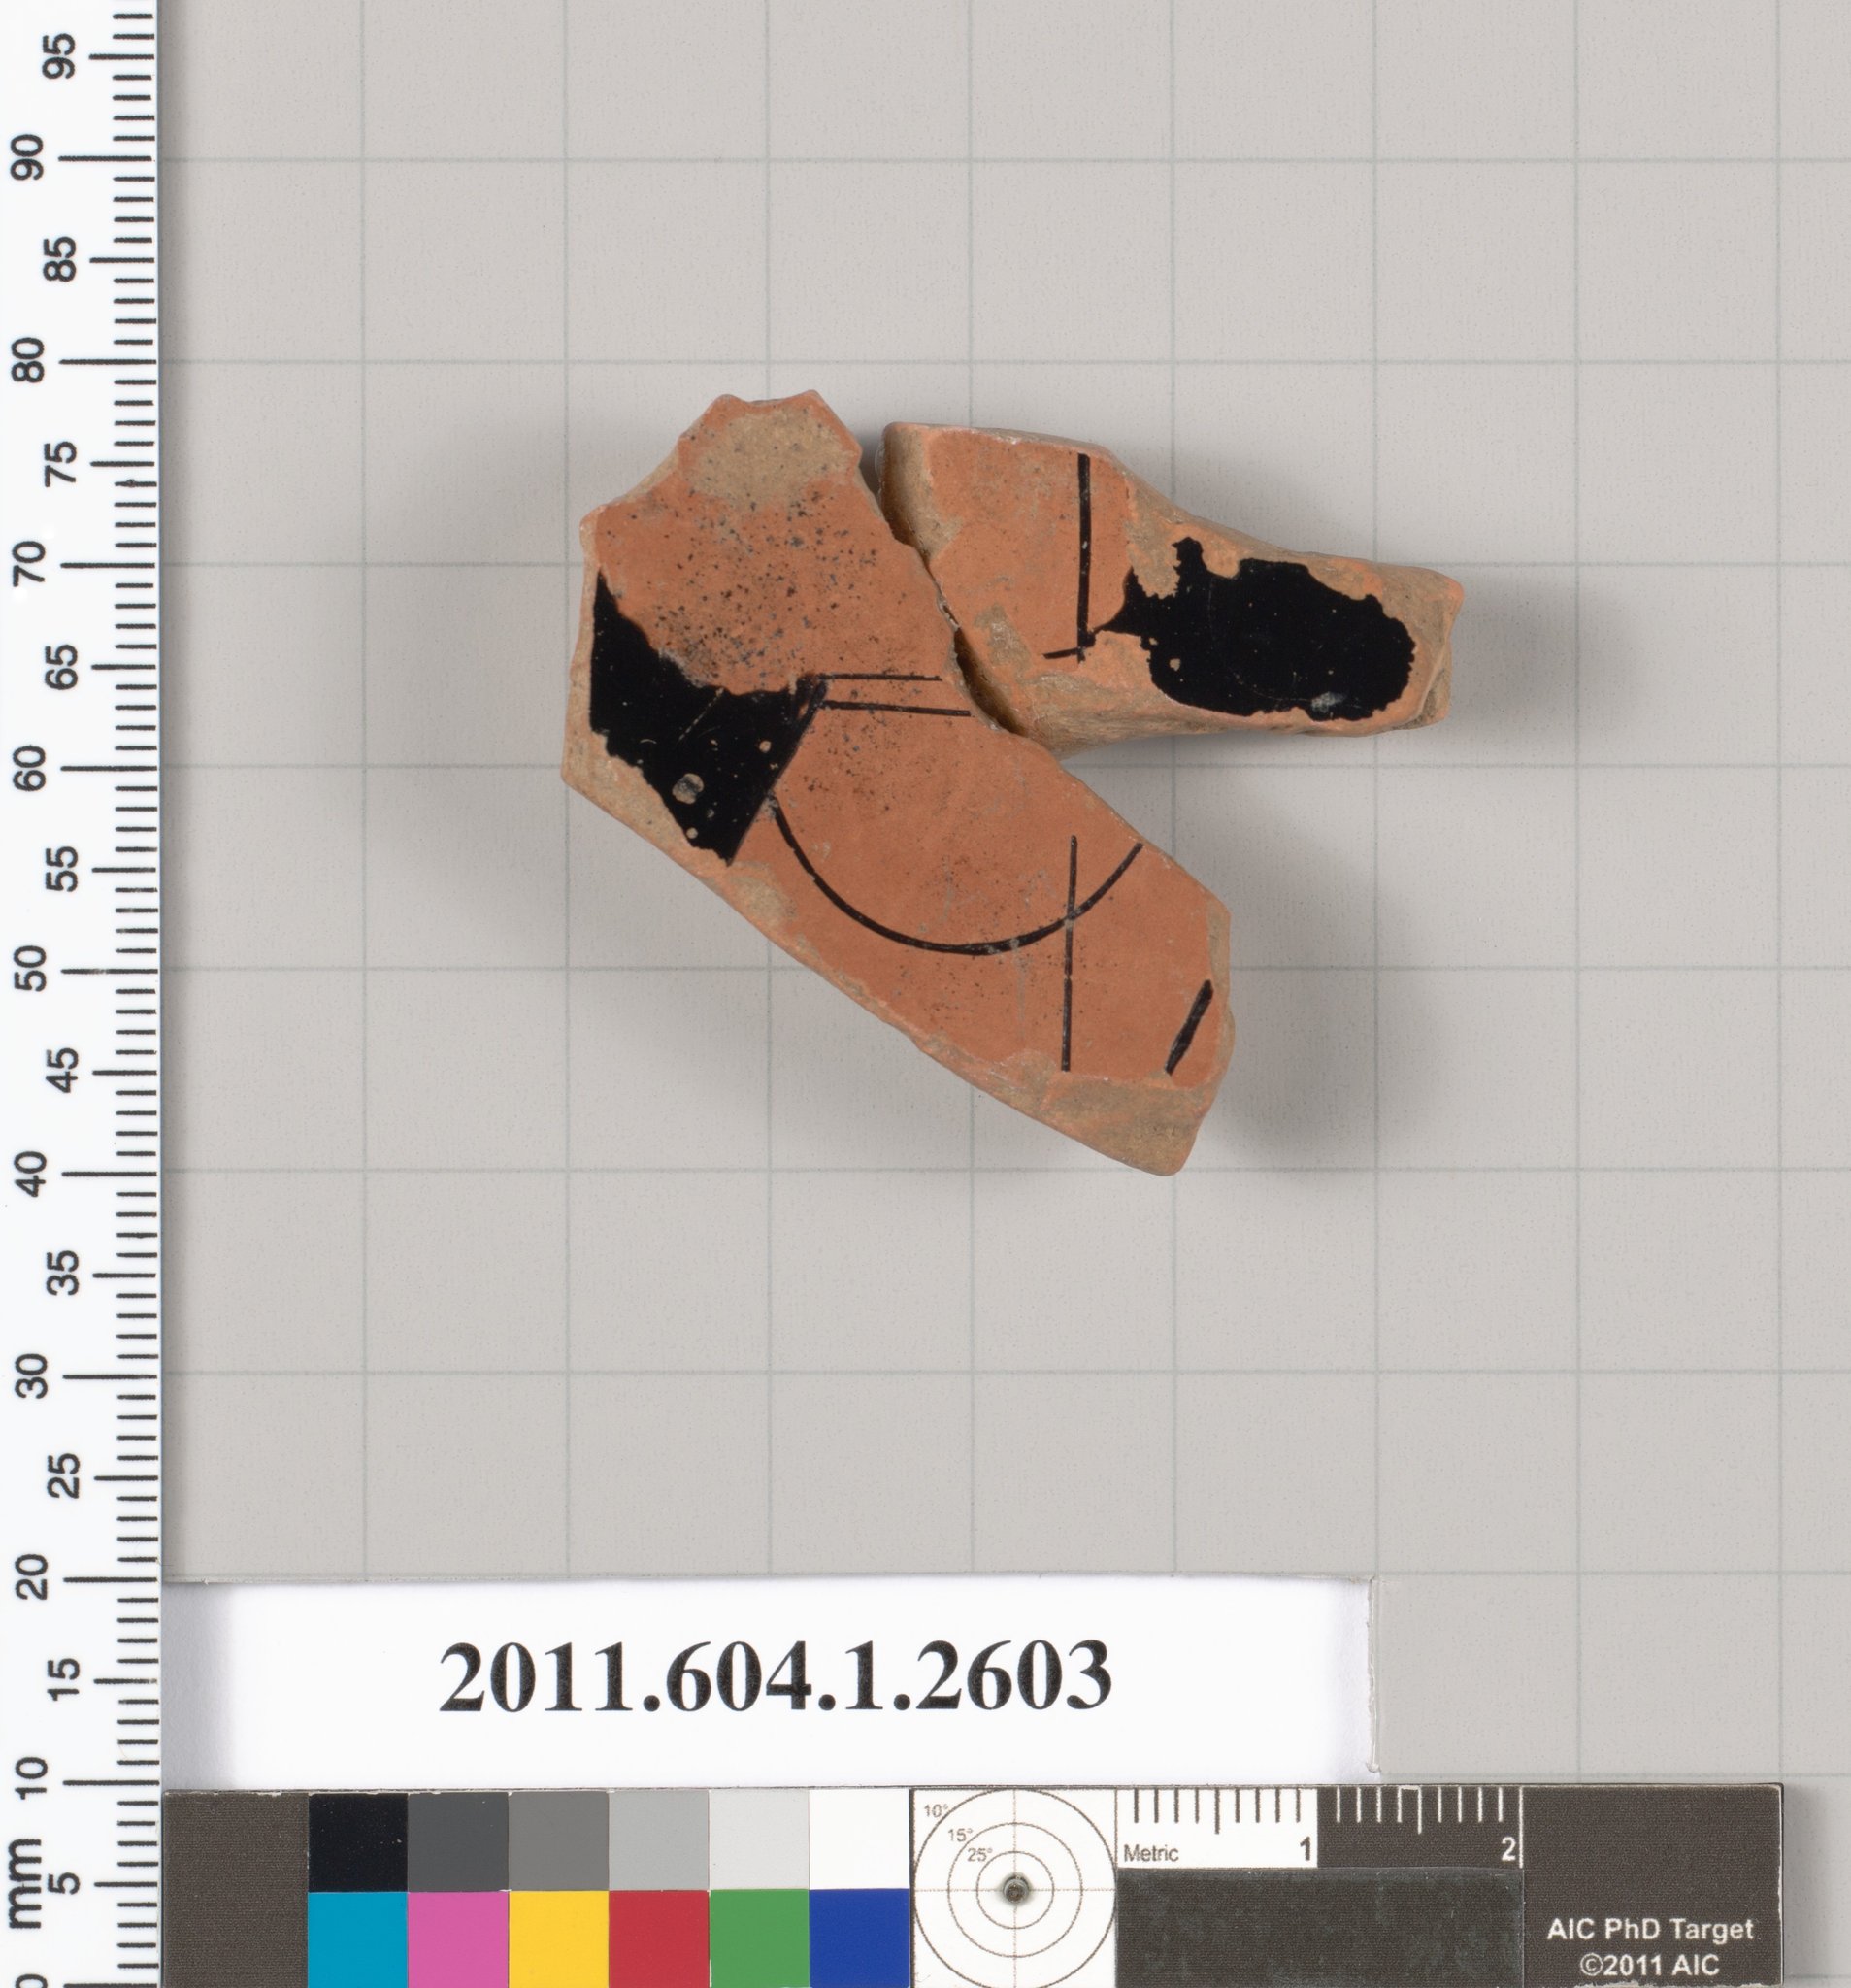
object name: kylix fragment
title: Terracotta fragment of a kylix (drinking cup)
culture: greek, attic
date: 500-451 BCE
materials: terracotta